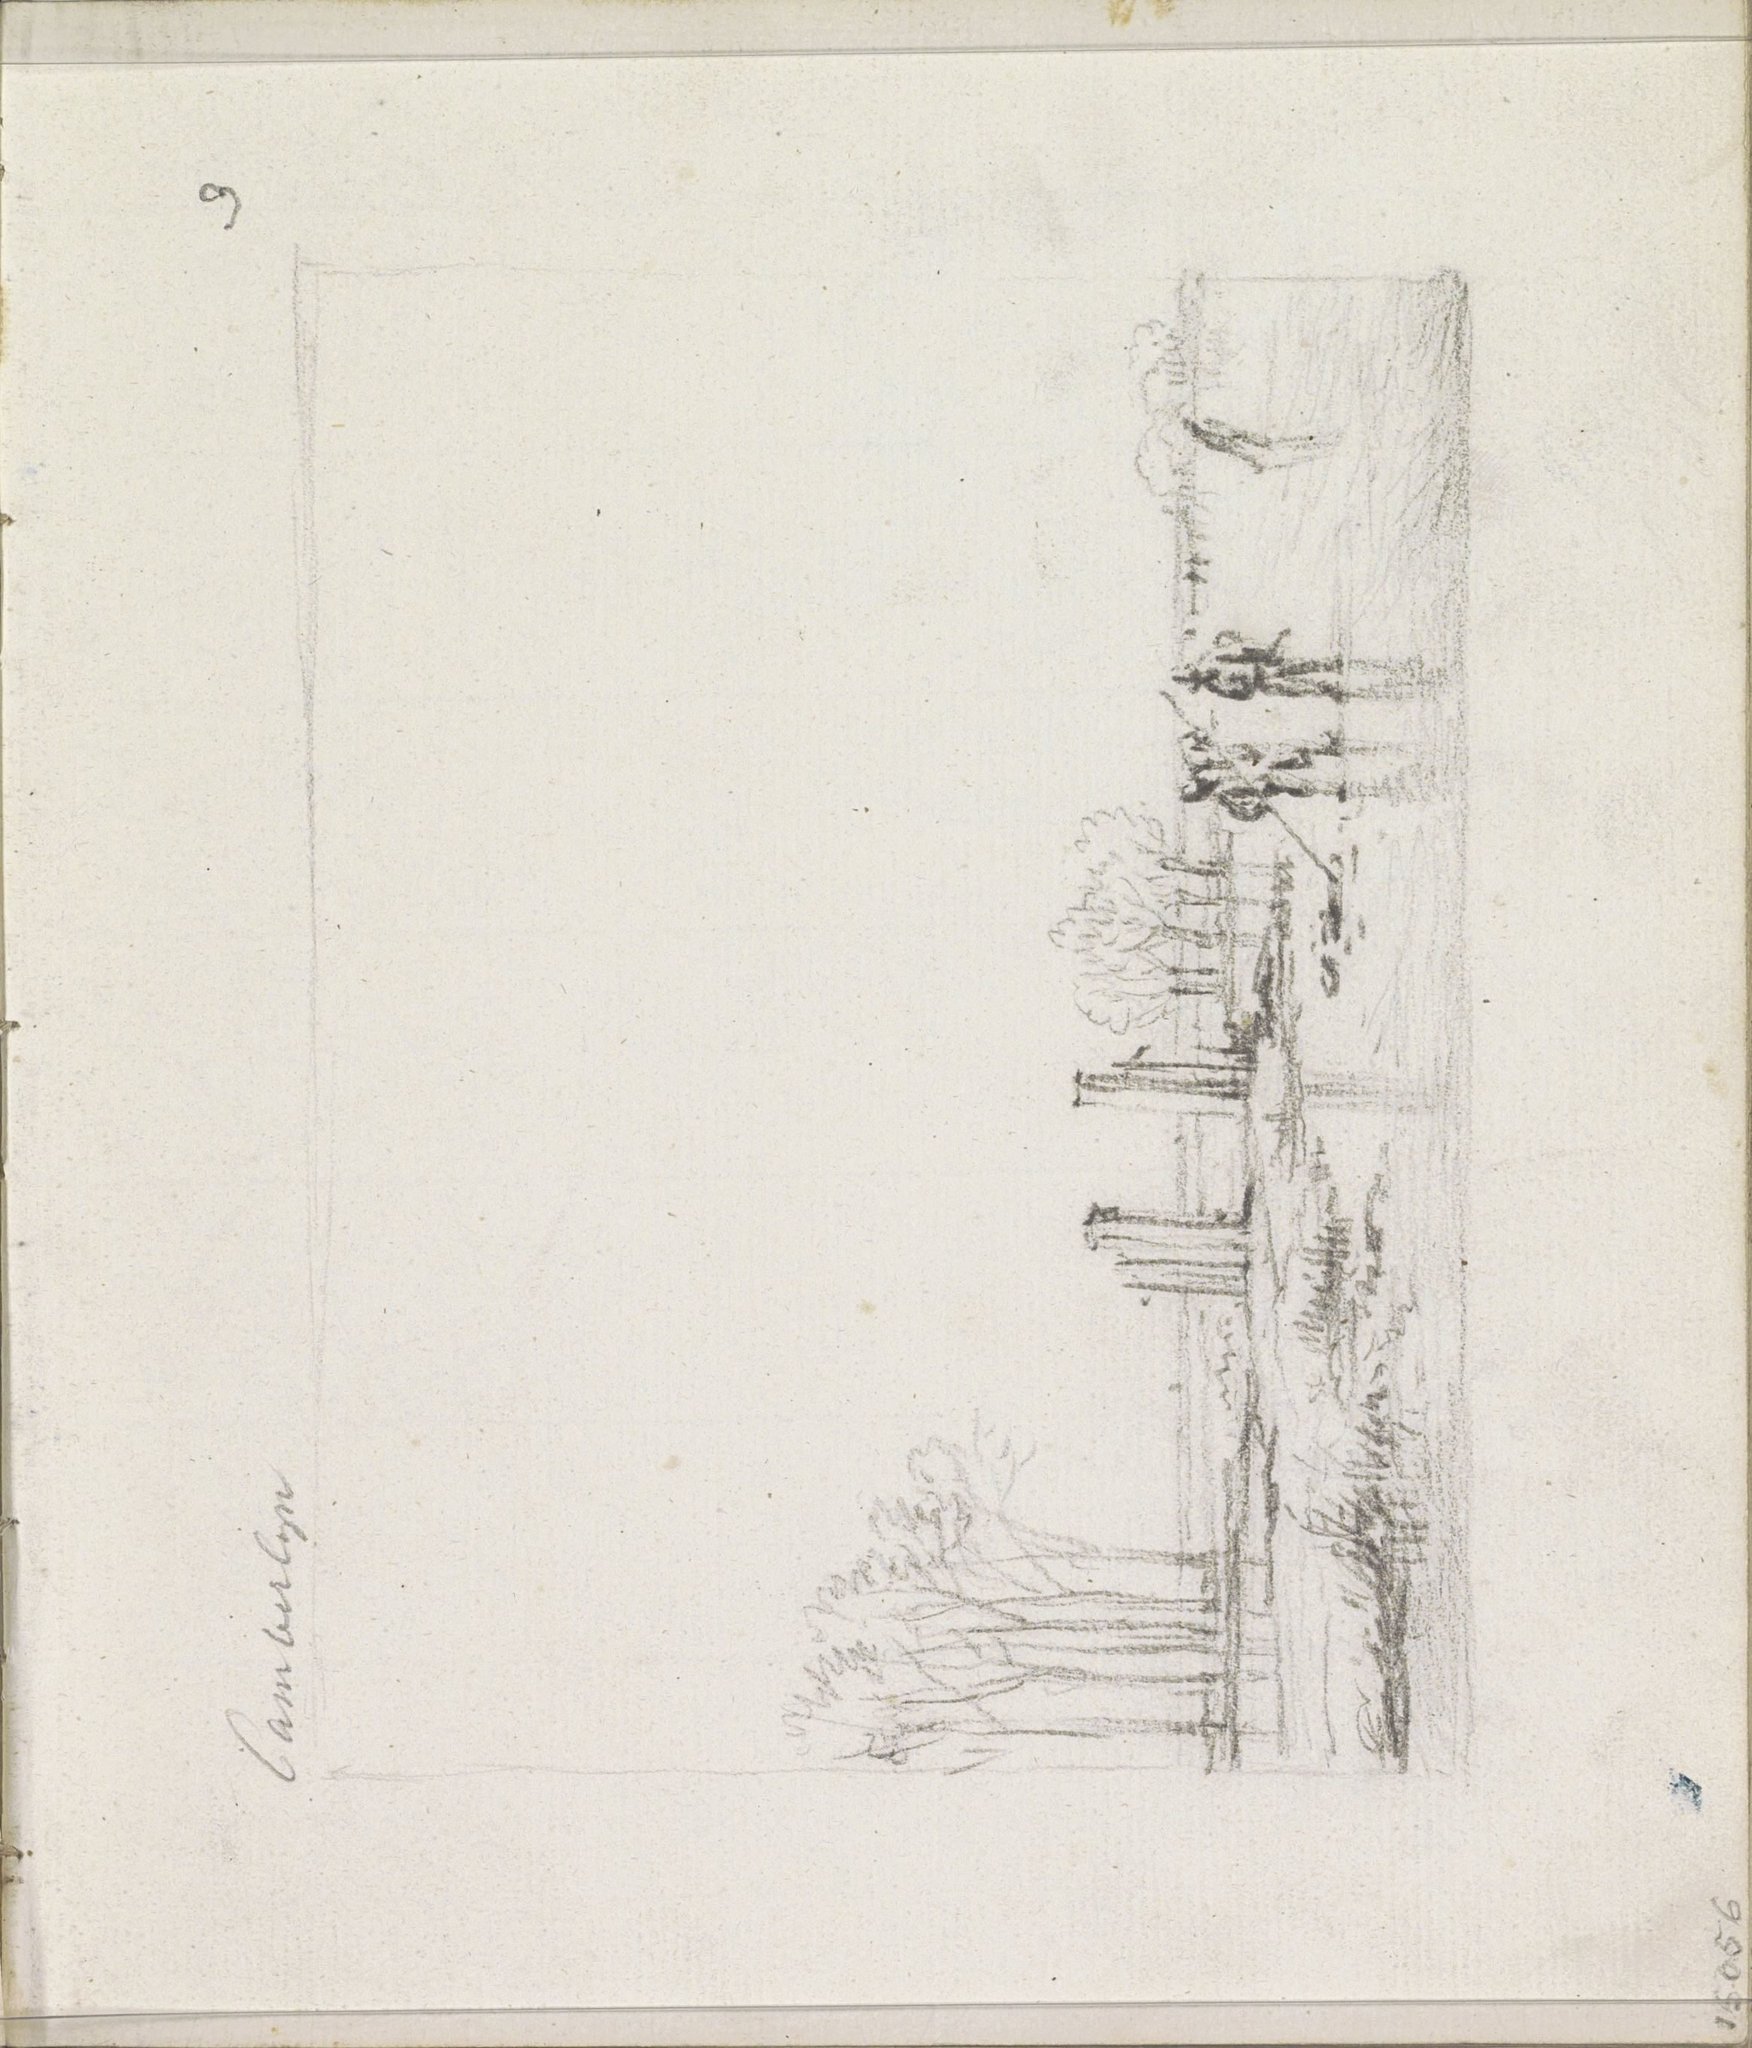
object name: sketchbook leaf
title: Landschap met figuren die een wak maken op een bevroren vaart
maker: andreas schelfhout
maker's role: draughtsman, painter, print maker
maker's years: 1787-1870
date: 1825-1829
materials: chalk, paper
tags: frost, freezing weather, landscapes (+ landscape with figures, staffage)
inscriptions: number: ‘3/ 15056’, annotation: ‘Camberlijn’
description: Op de achtergrond ook schaatsers. Blad 17 recto uit een schetsboek met 95 bladen.